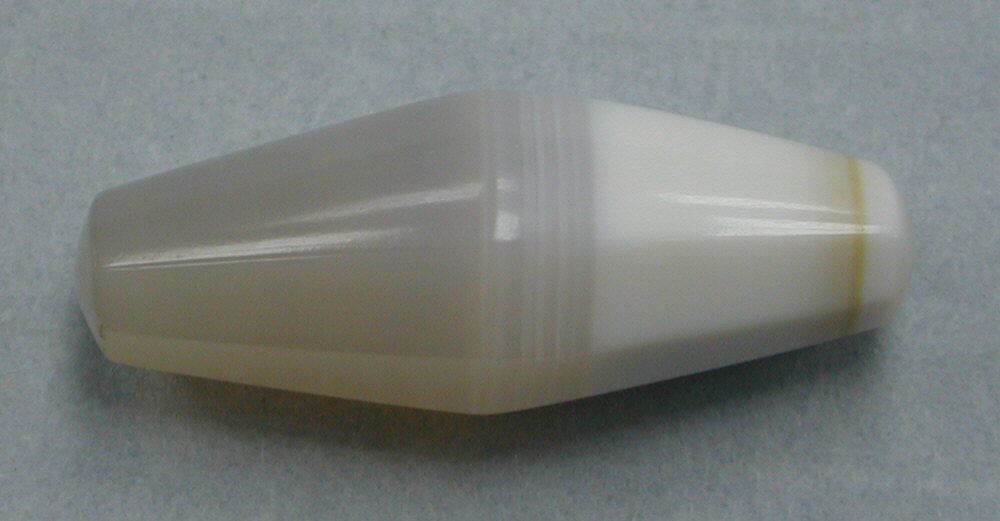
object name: ritual stone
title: Polishing Stone (pulidor)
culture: mexican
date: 1501-1600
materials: stone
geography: mexico